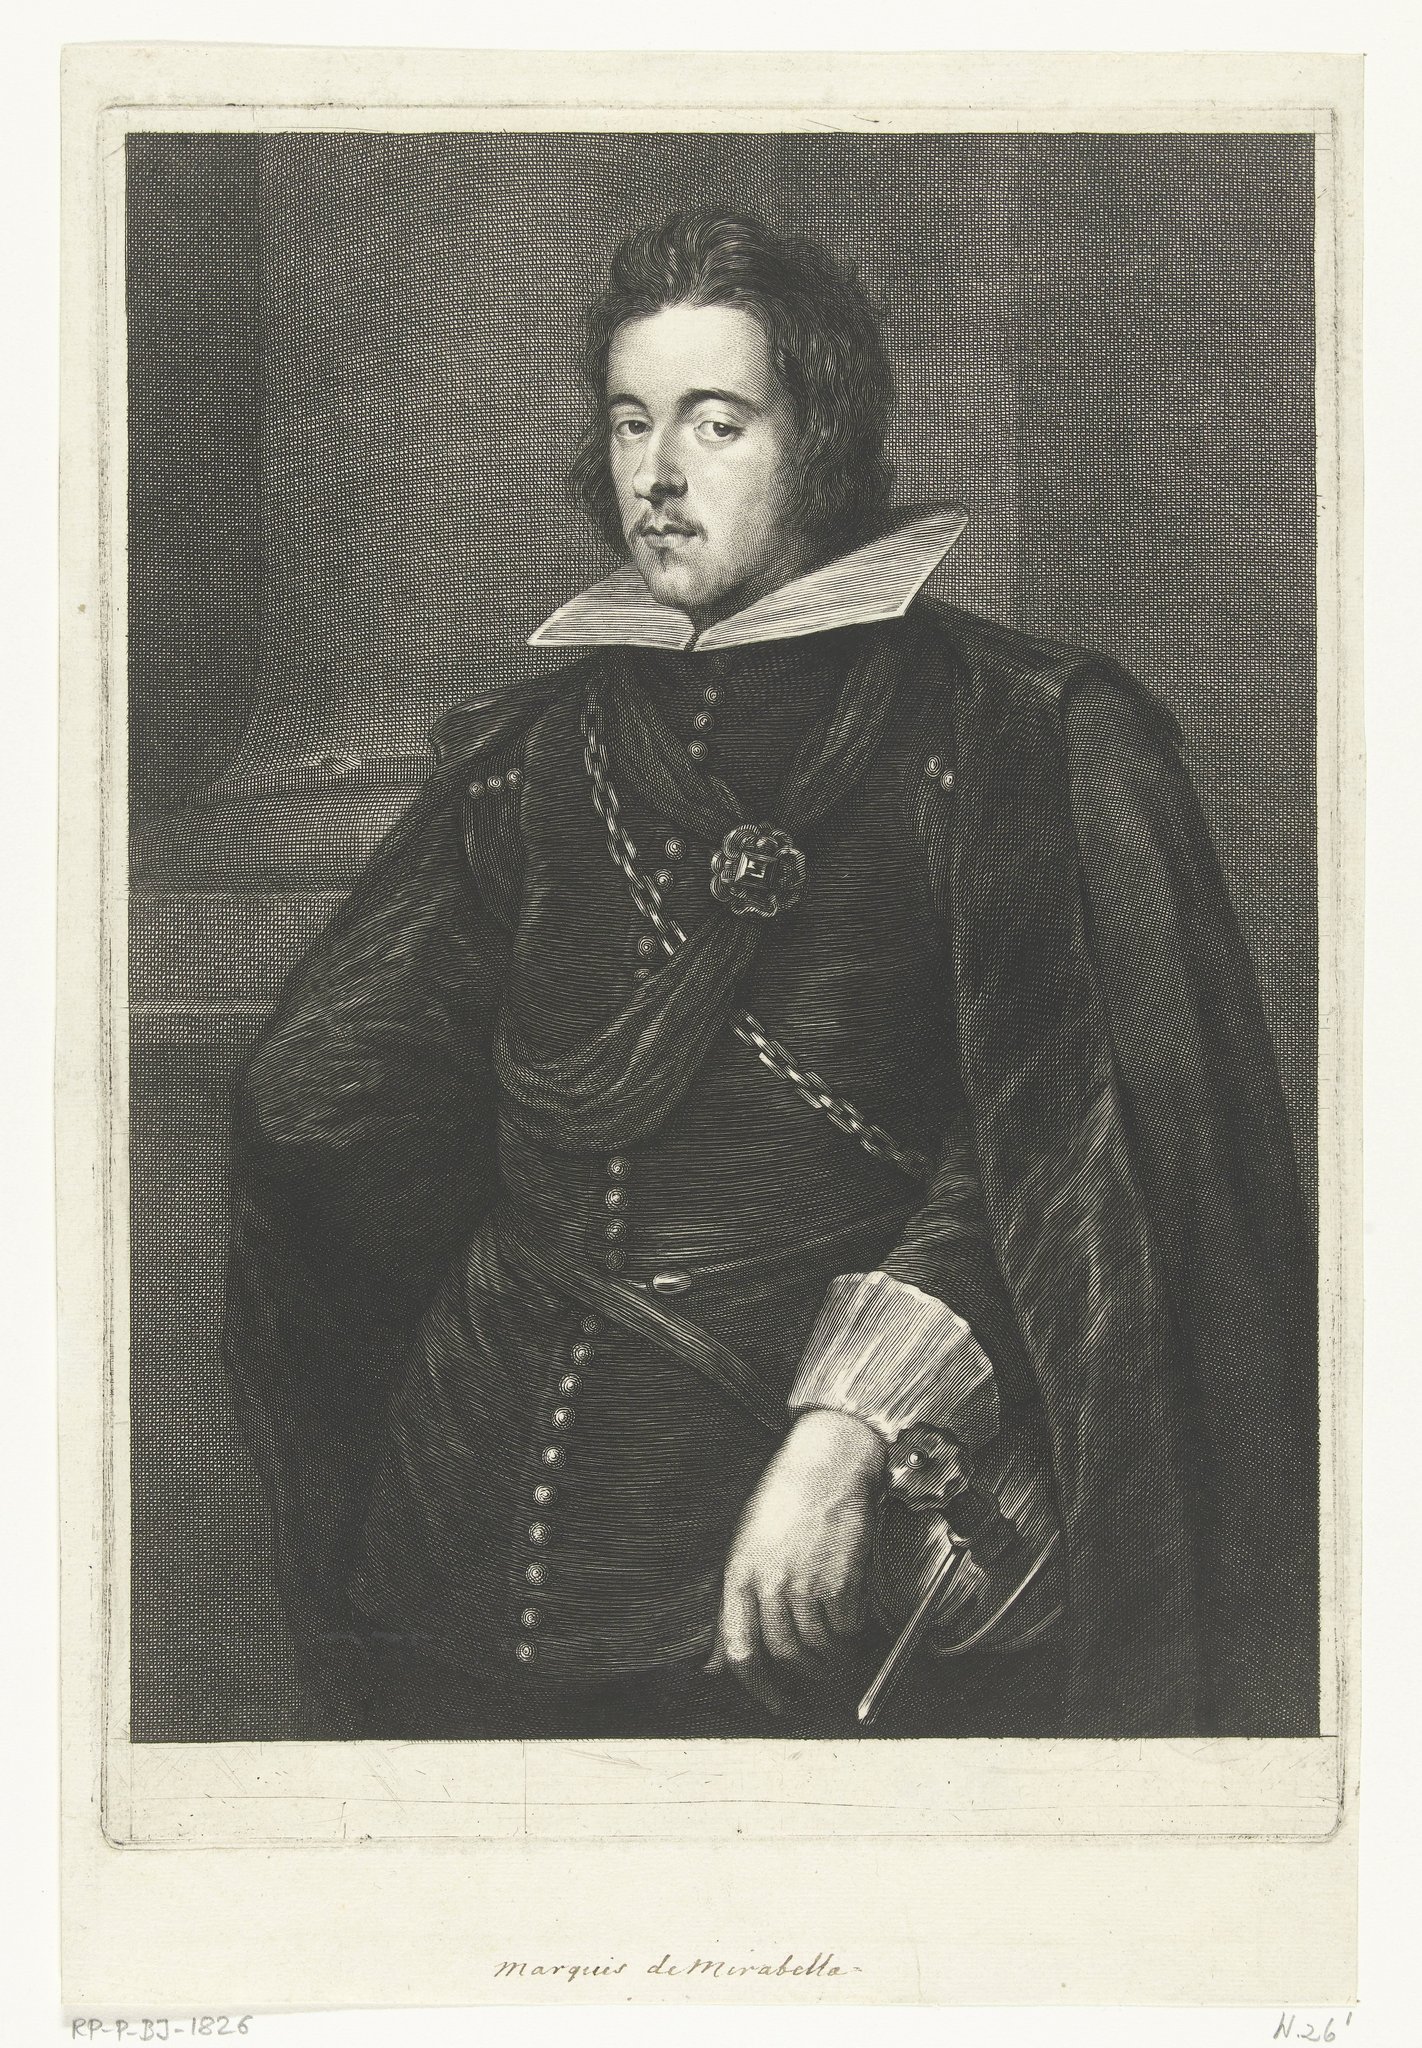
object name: print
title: Portret van de Marquis de Mirabeau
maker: abraham bloteling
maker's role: draughtsman, print maker, publisher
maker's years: 1640-1690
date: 1675-1690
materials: paper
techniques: engraving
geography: netherlands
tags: paris, politician, honoré-gabriel de riqueti (graaf van mirabeau)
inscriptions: collector's mark: Lugt 2228, collector's mark: Lugt 240, inscription: ‘Marquis de Mirabella’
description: Portret van Honoré de Riqueti marquis de Mirabeau, Spaanse ambassadeur in Parijs als jonge man.